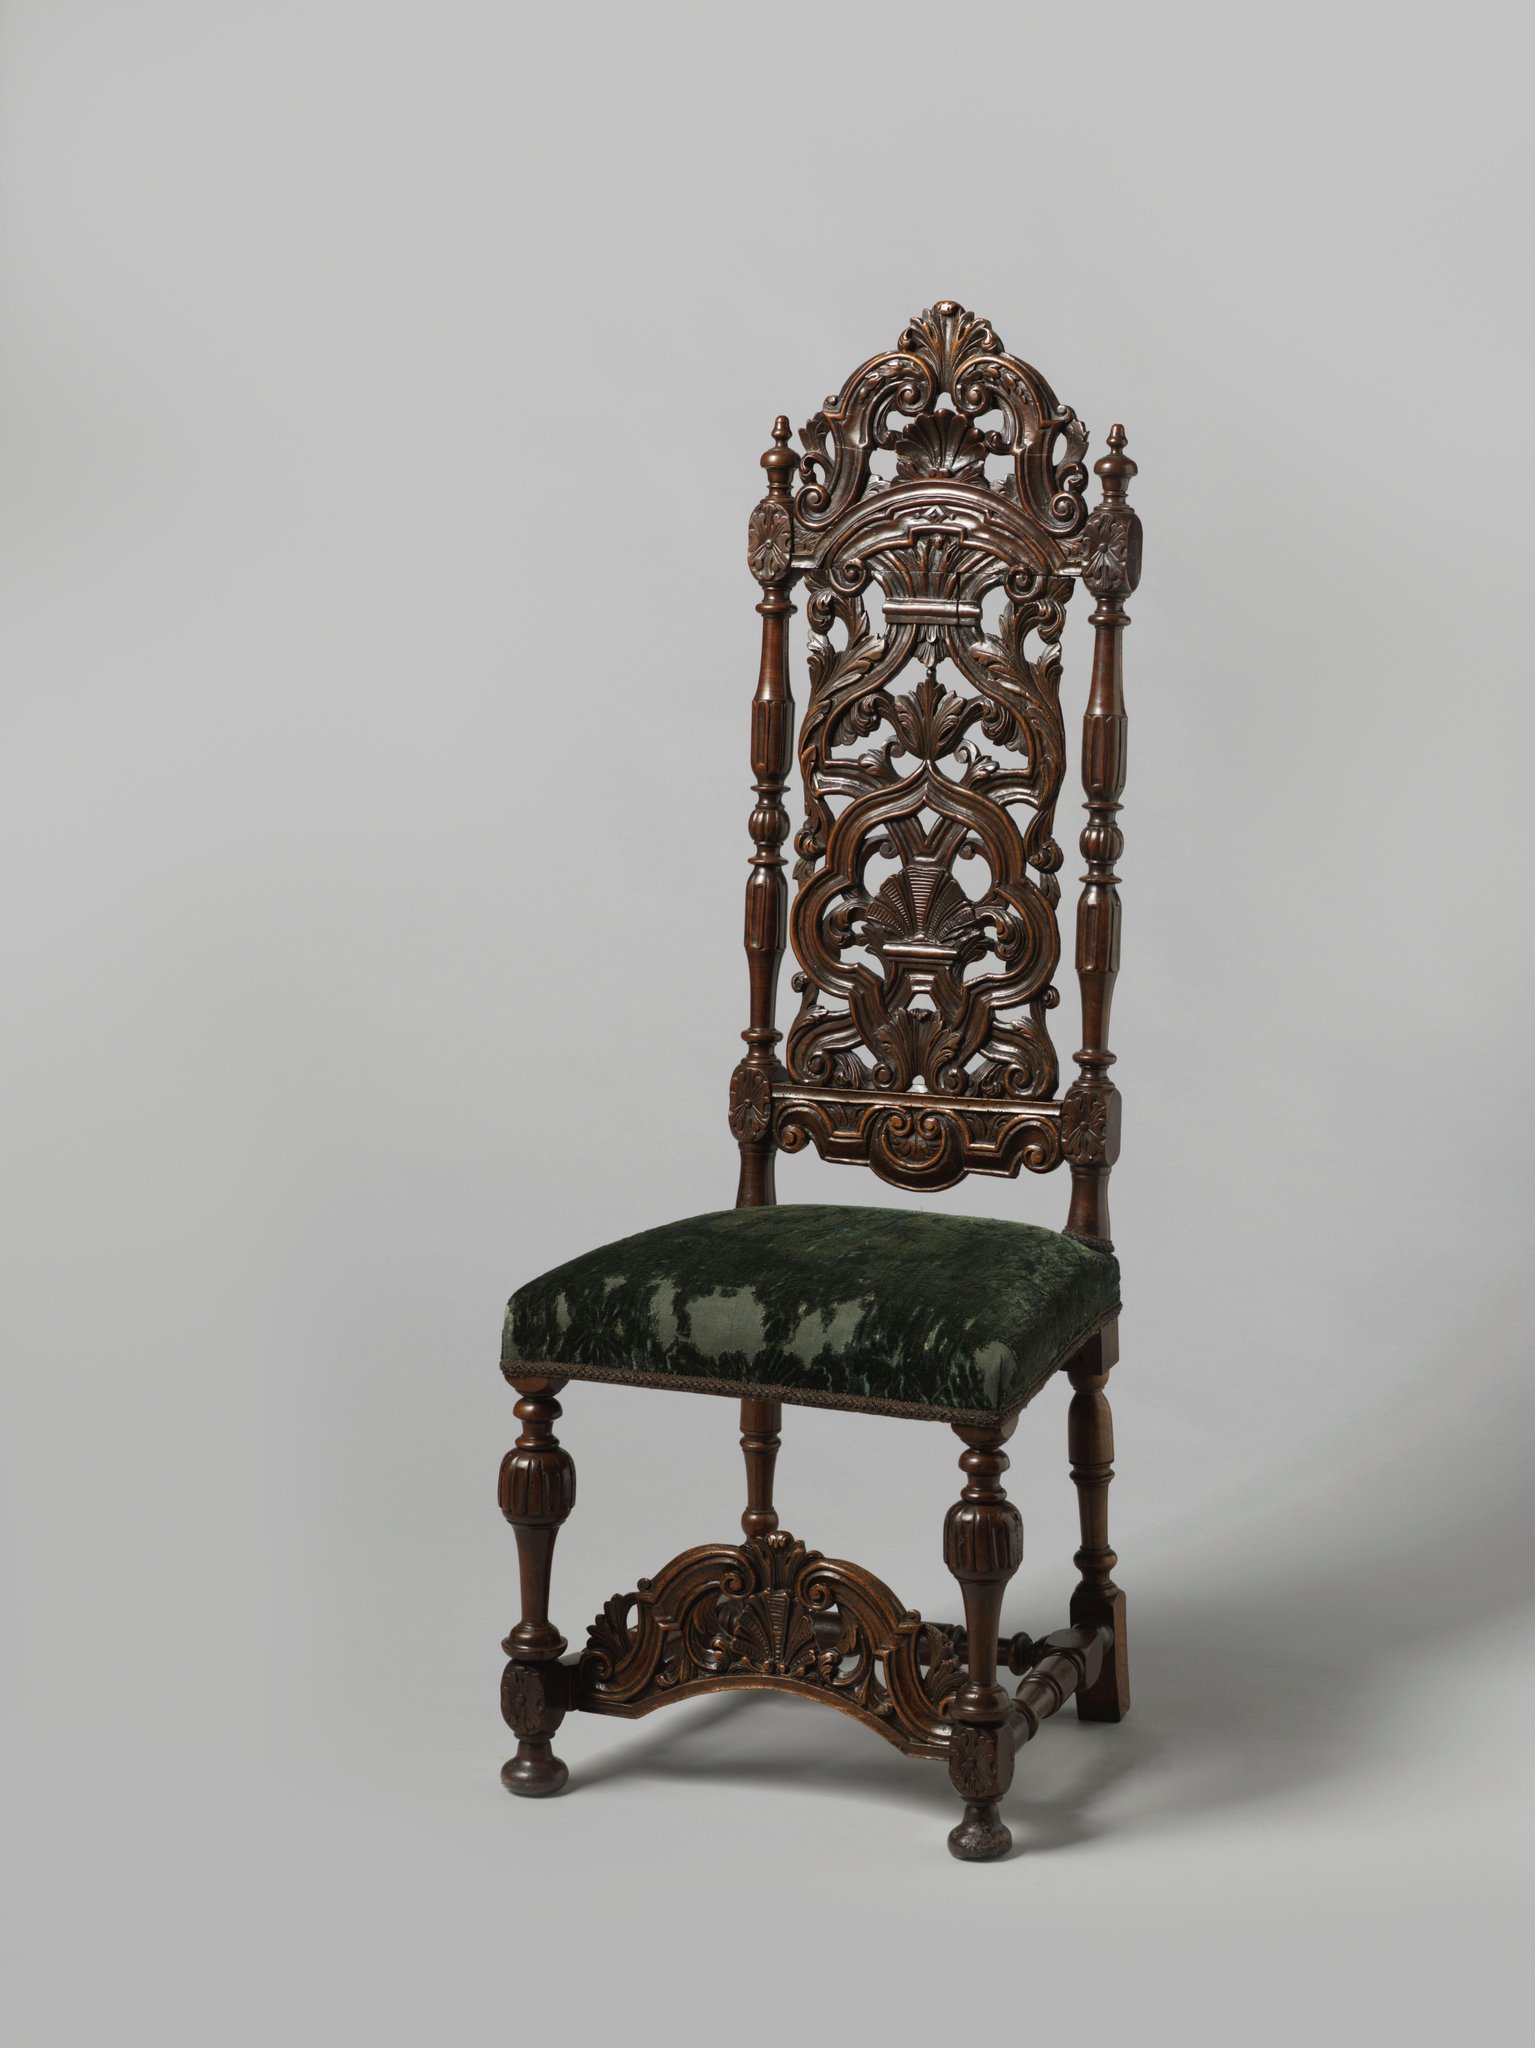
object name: chair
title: Stoel met beklede zitting en gebeeldhouwde opengewerkte rug. Versiering van gebroken voluten, schelpmotieven en acanthusblad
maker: Anonymous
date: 1700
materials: velvet, wood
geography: netherlands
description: Stoel van notenhout. Het meubel heeft een beklede zitting en balustervormige voorpoten met kwastvormige verdikking van het bovenste deel. De voorsport heeft opengewerkte gebroken S-voluten met acanthusbladeren ter weerszijden van een schelp. De hoge, opengewerkte en gebeeldhouwde rug rust op gedraaide stutten en heeft gelede vrijstaande hoekstijlen. Boven- en onderdorpel zijn geschulpt en vertonen gebroken voluten, schelpmotieven en acanthusblad. Binnen het raam een schelpmotief, acantusblad en bandwerk. De bekleding nieuw.